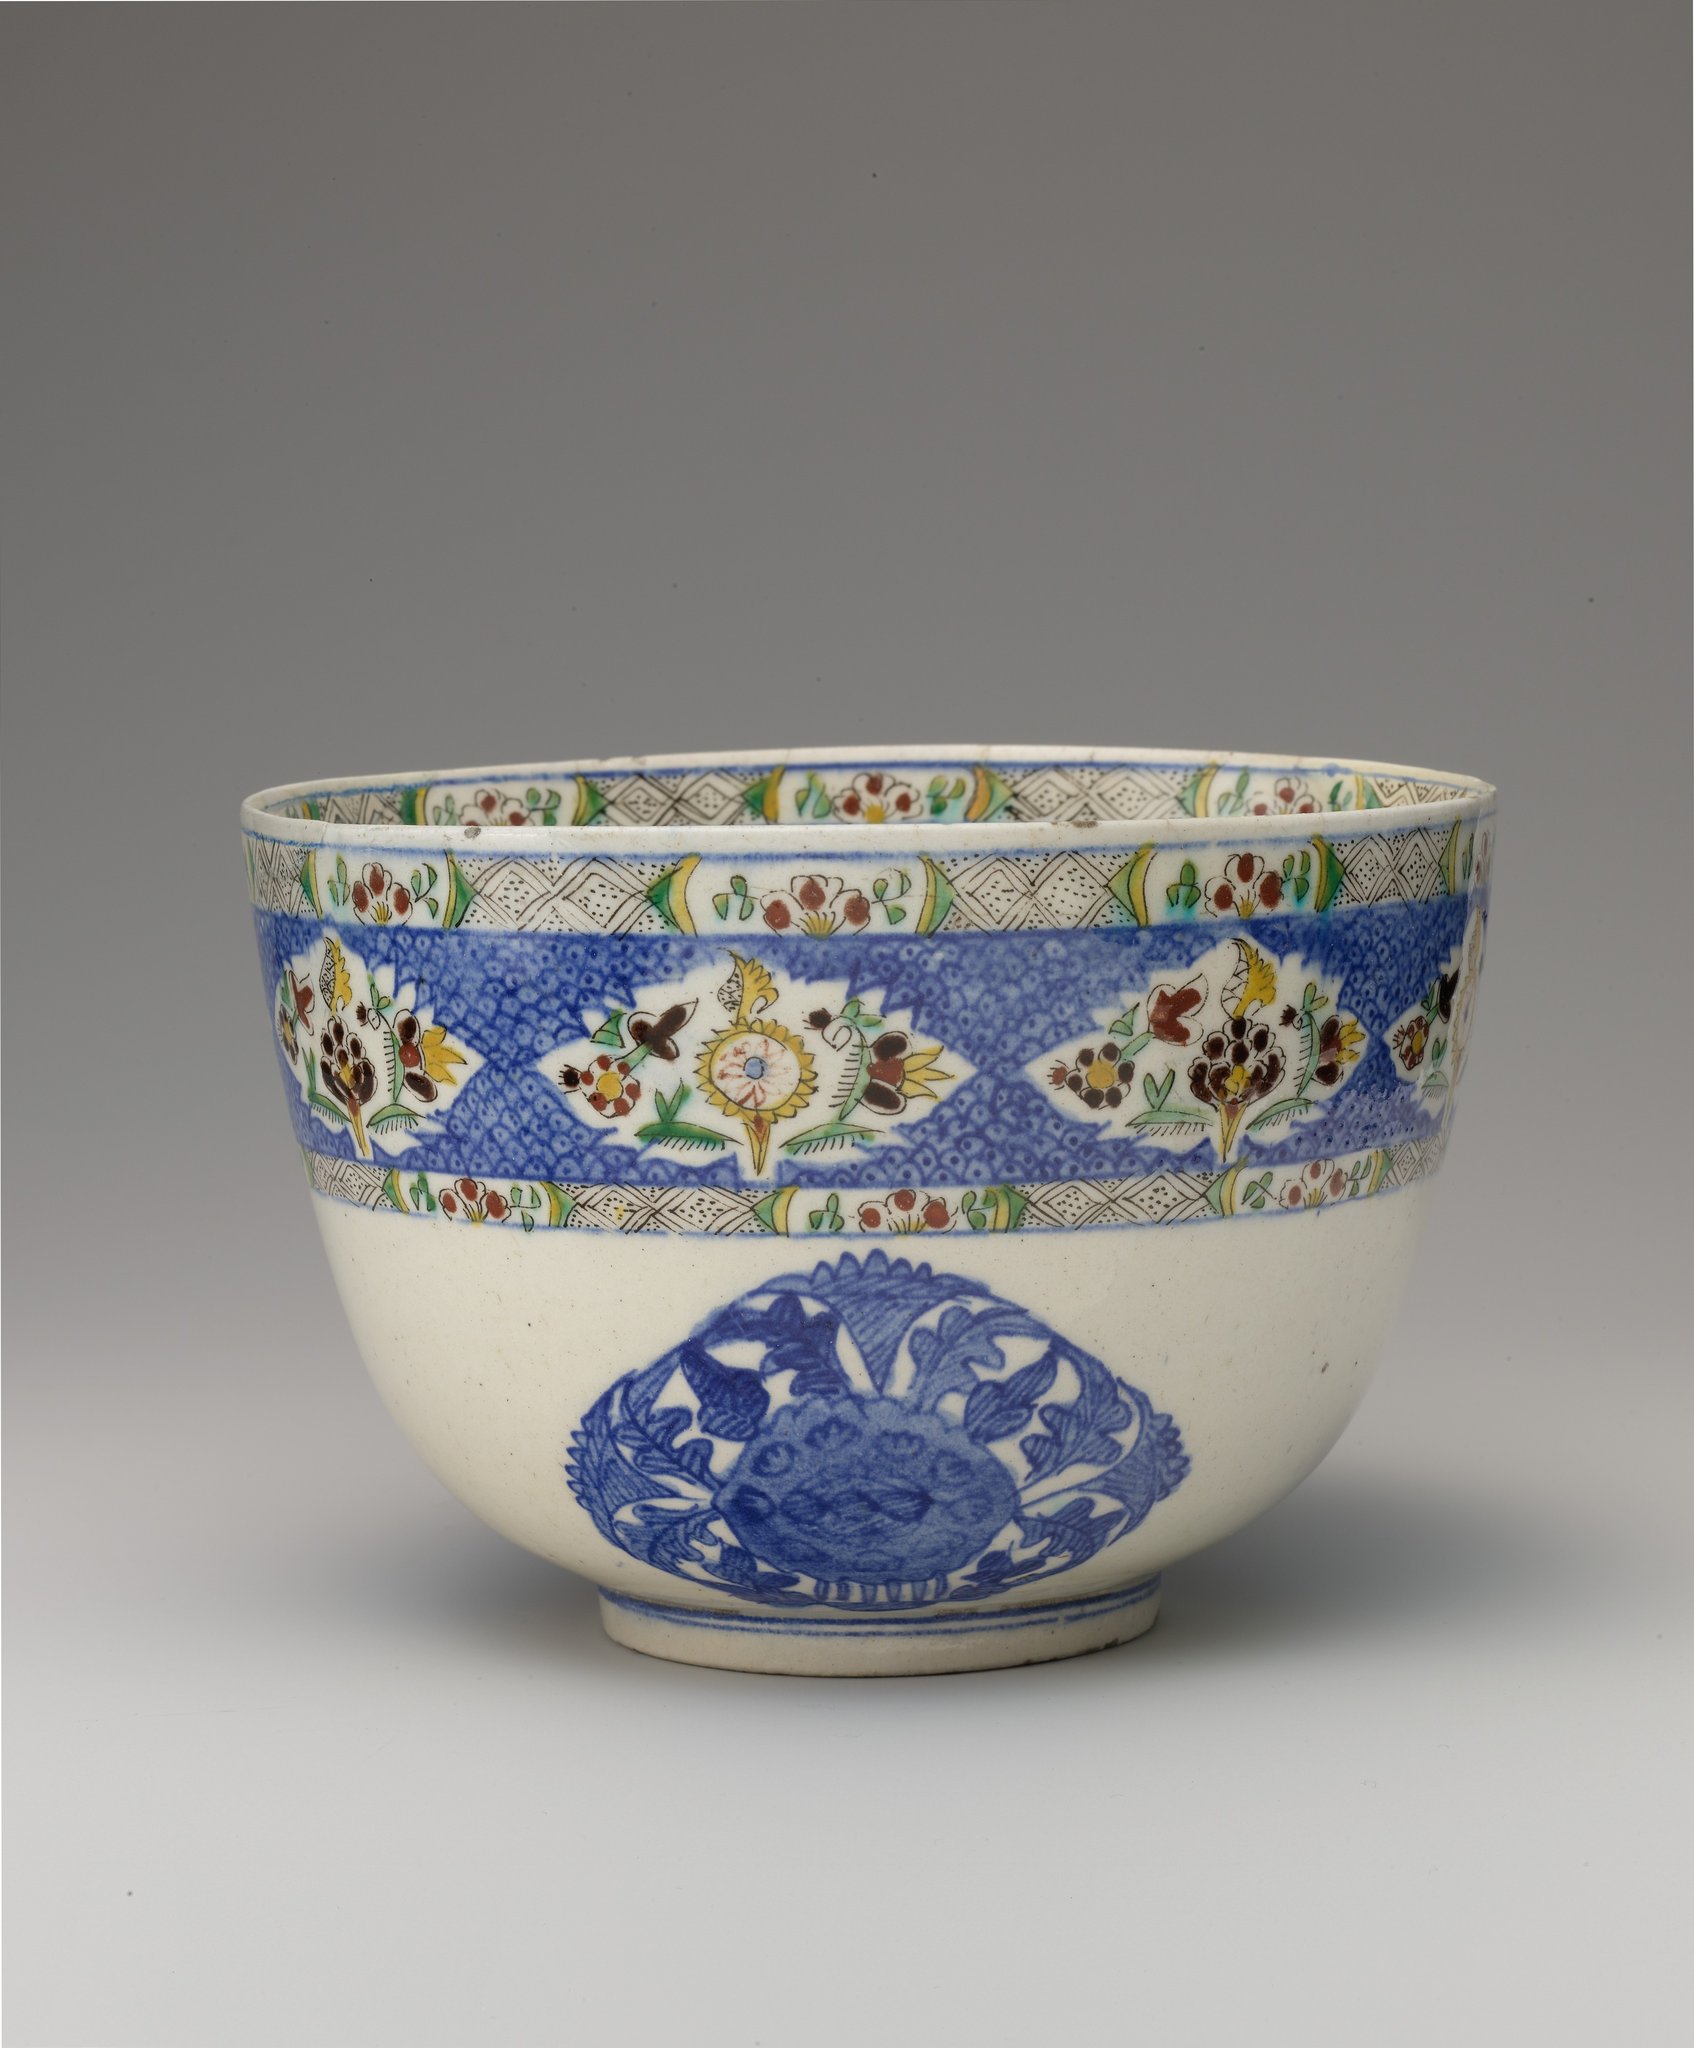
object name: bowl with lid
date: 1601-1800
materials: glaze, stonepaste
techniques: painting, polychrome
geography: turkey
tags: flowers